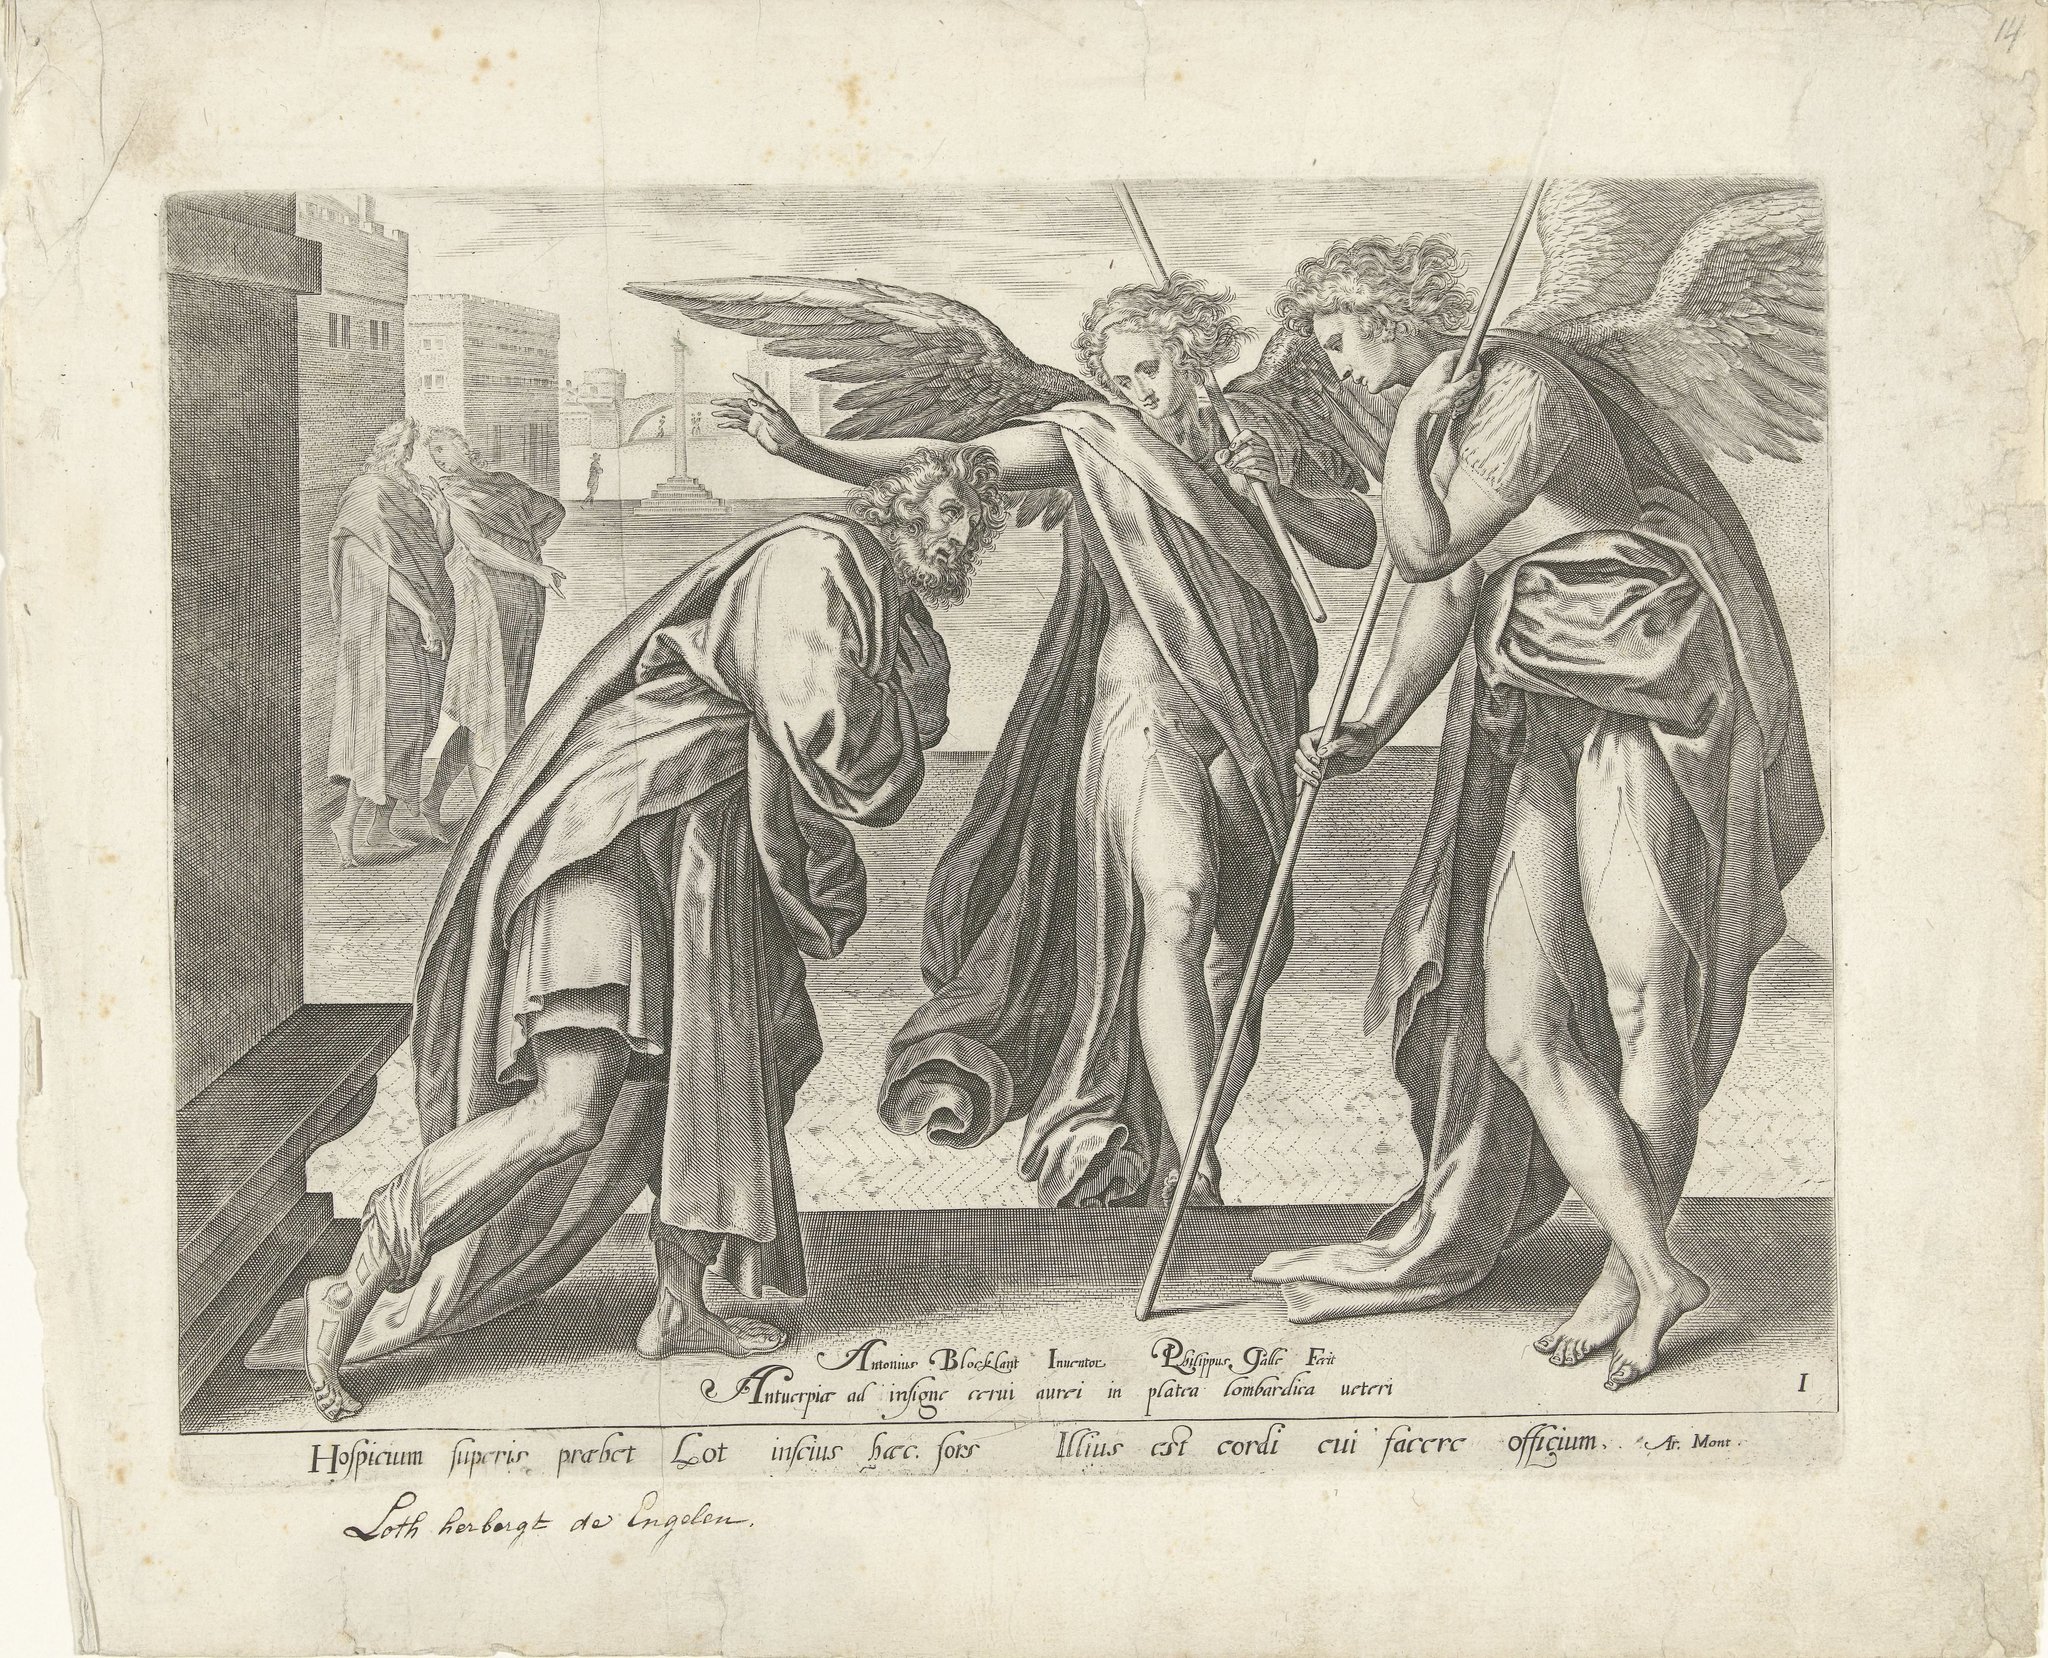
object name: print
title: Lot ontmoet de twee engelen aan de poort van Sodom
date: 1557-1570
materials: paper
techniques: engraving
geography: haarlem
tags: the angels find lot sitting at the gateway of the city; he arises and kneels before them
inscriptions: inscription: ‘Loth herbergt de Engelen.’, collector's mark: Lugt 2228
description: Lot buigt voor de twee engelen die hij ontmoet aan de stadspoort van Sodom. De engelen dragen elk een stok met zich mee. Op de achtergrond een plein in Sodom.